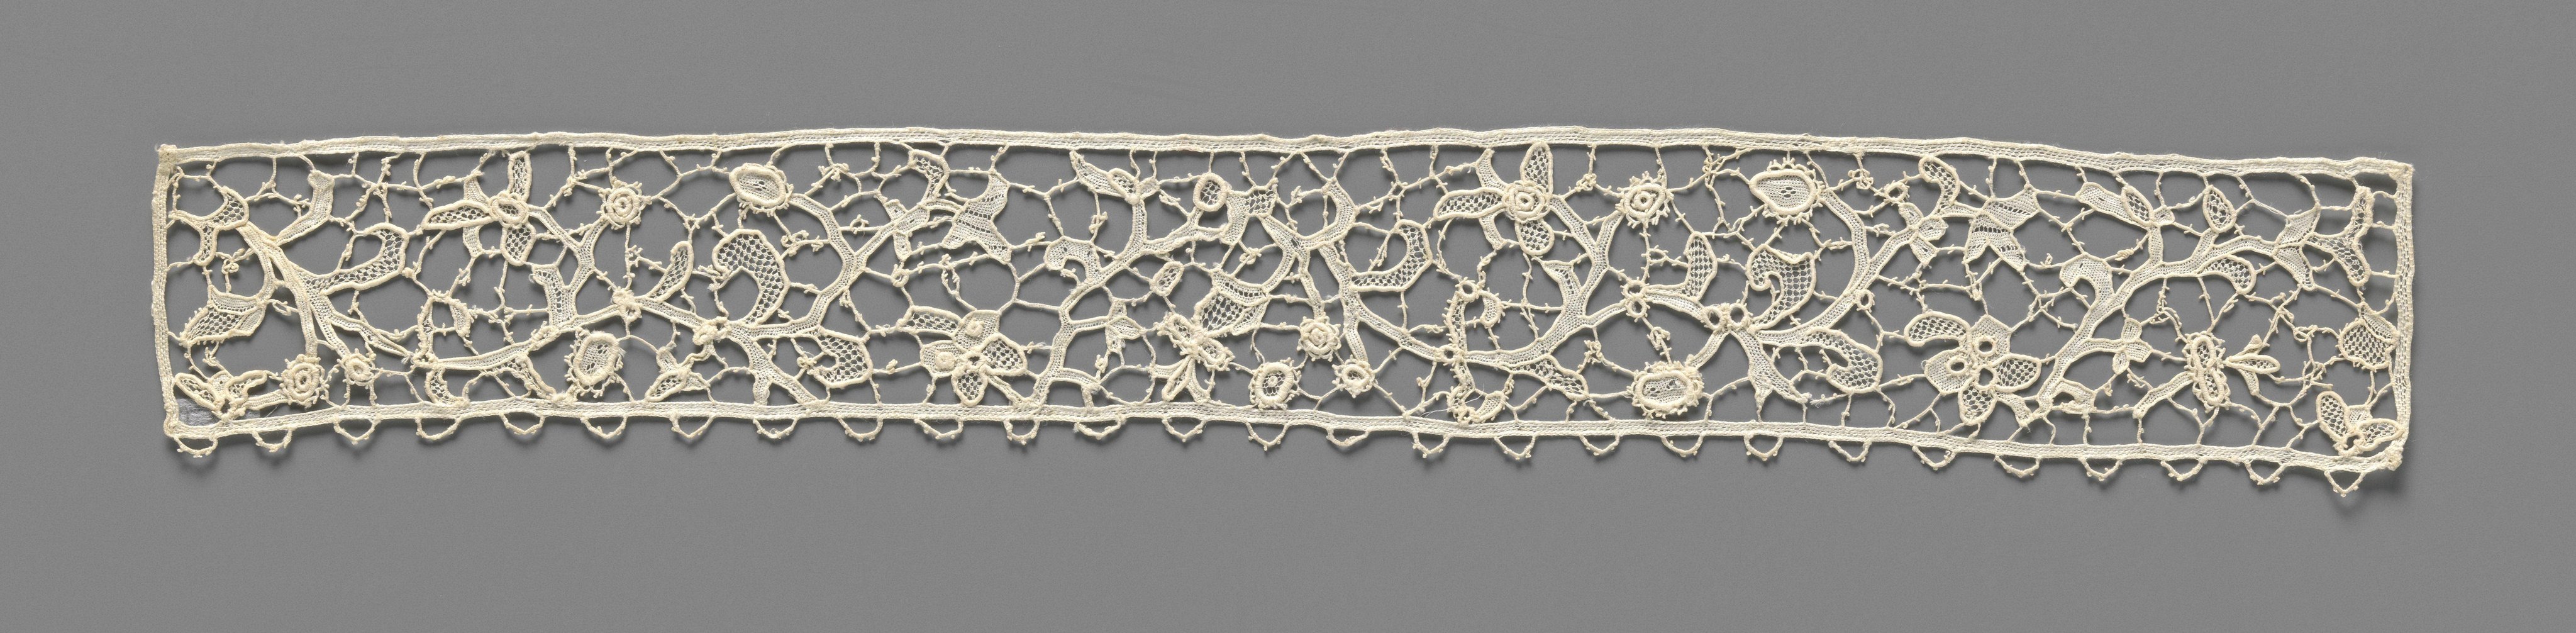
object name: strip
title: Strook naaldkant met spichtige ranken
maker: Anonymous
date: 1890-1899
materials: linen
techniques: rose point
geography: burano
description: Strook naturelkleurige naaldkant: Venetiaanse rozenkant. Zeer open spijlengrond met breed golvende, spichtige, vertakte ranken, die onder andere versierd zijn met roosjes.